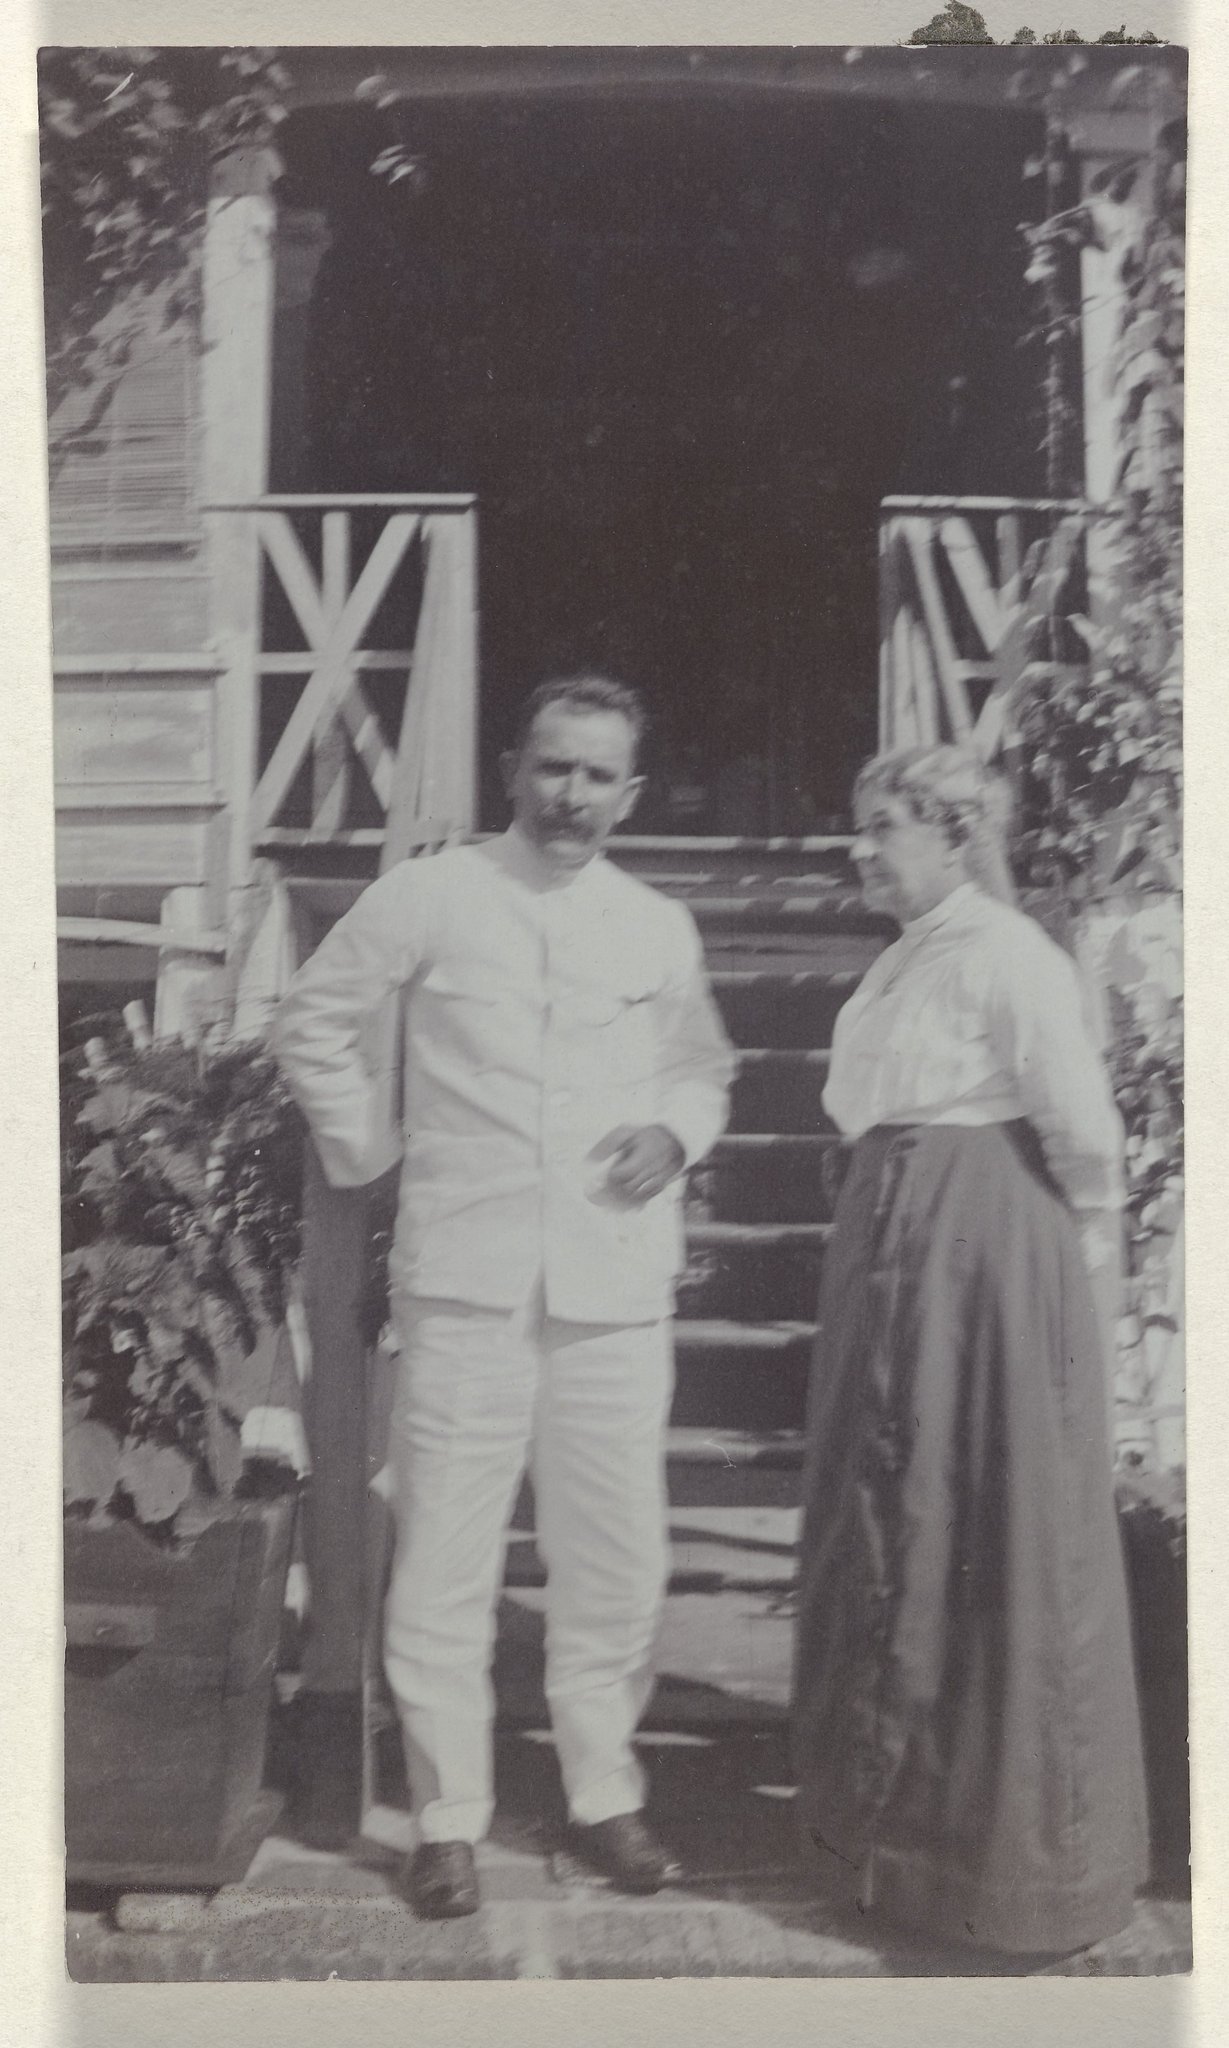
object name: photograph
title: Justus Gonggrijp samen met Anna Rühmann op plantage Clevia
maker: andries augustus boom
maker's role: amateurfotograaf, handelaar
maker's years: 1878-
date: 1912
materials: photographic support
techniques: photography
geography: suriname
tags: justus gonggrijp, plantation, suriname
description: Justus Gonggrijp samen met Anna Rühmann staande voor de trap naar het huis op plantage Clevia. Onderdeel van een groep foto's van de familie Boom-Gonggrijp in Suriname.